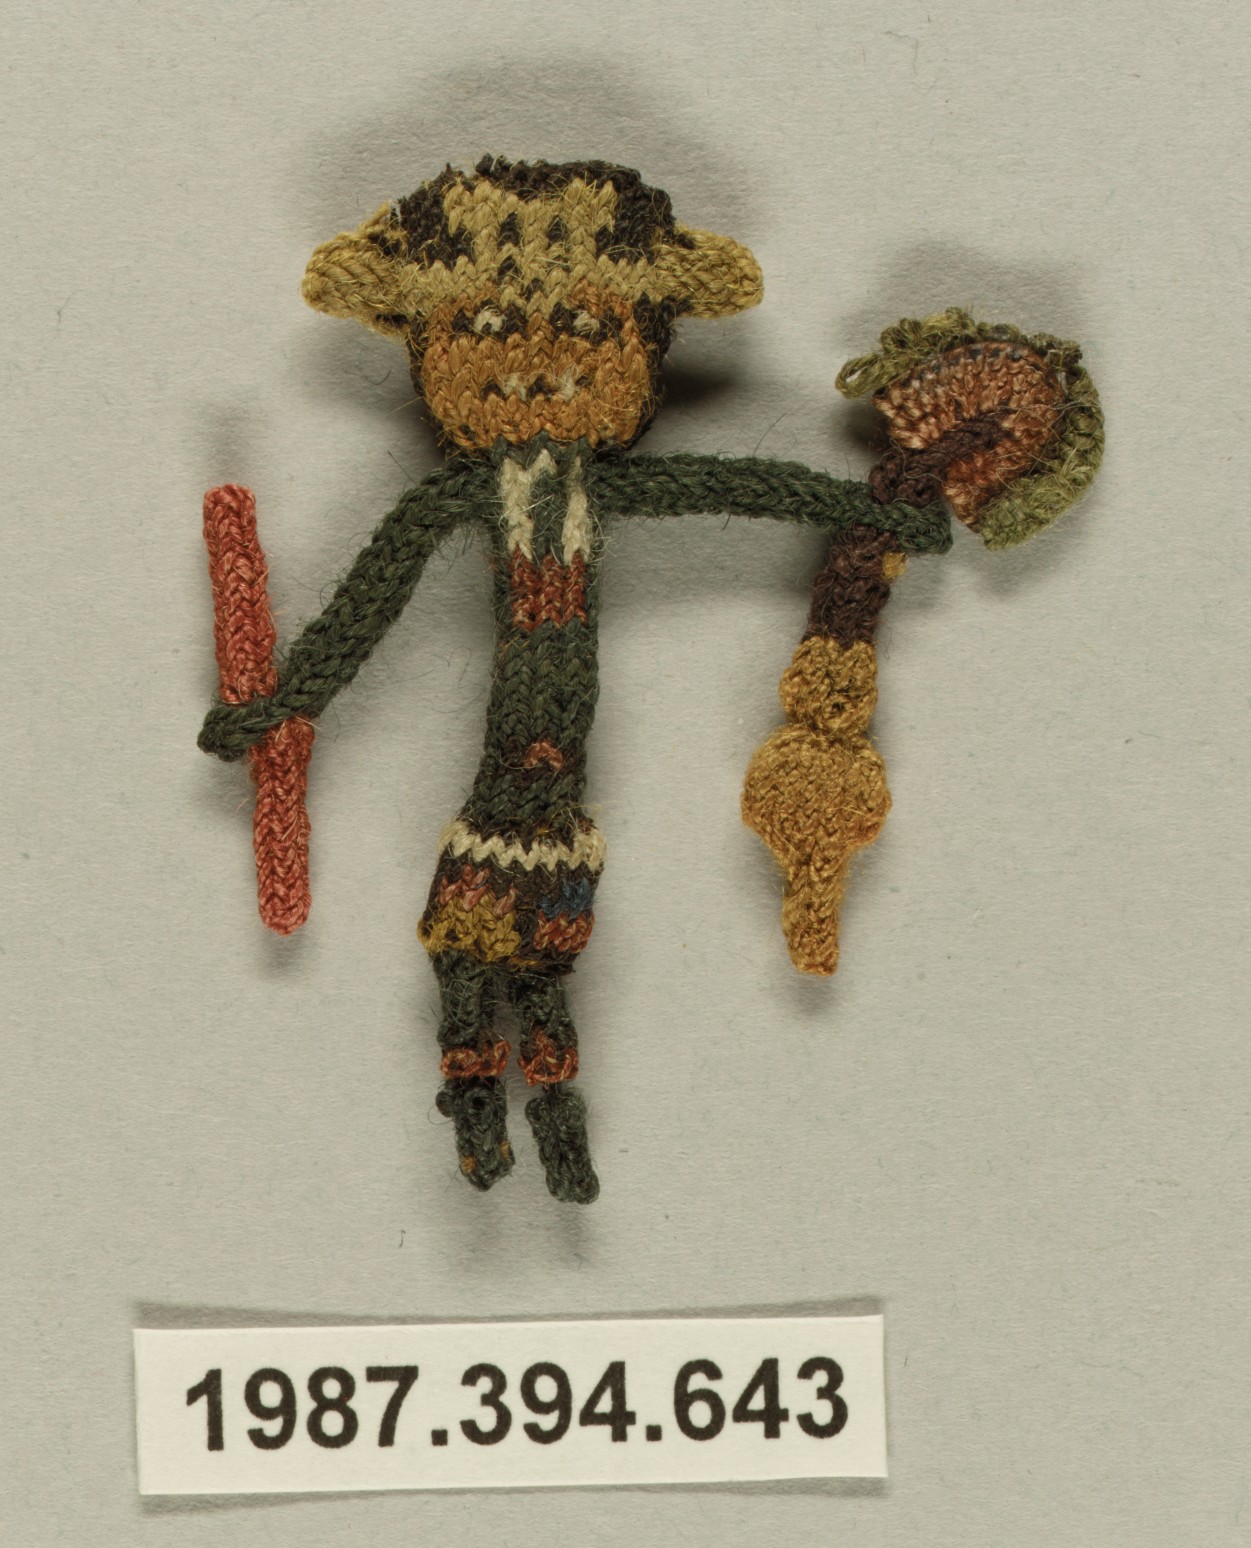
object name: figure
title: Border Fragment, Figure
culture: nasca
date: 200-101 BCE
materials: animal fiber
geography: peru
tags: human figures